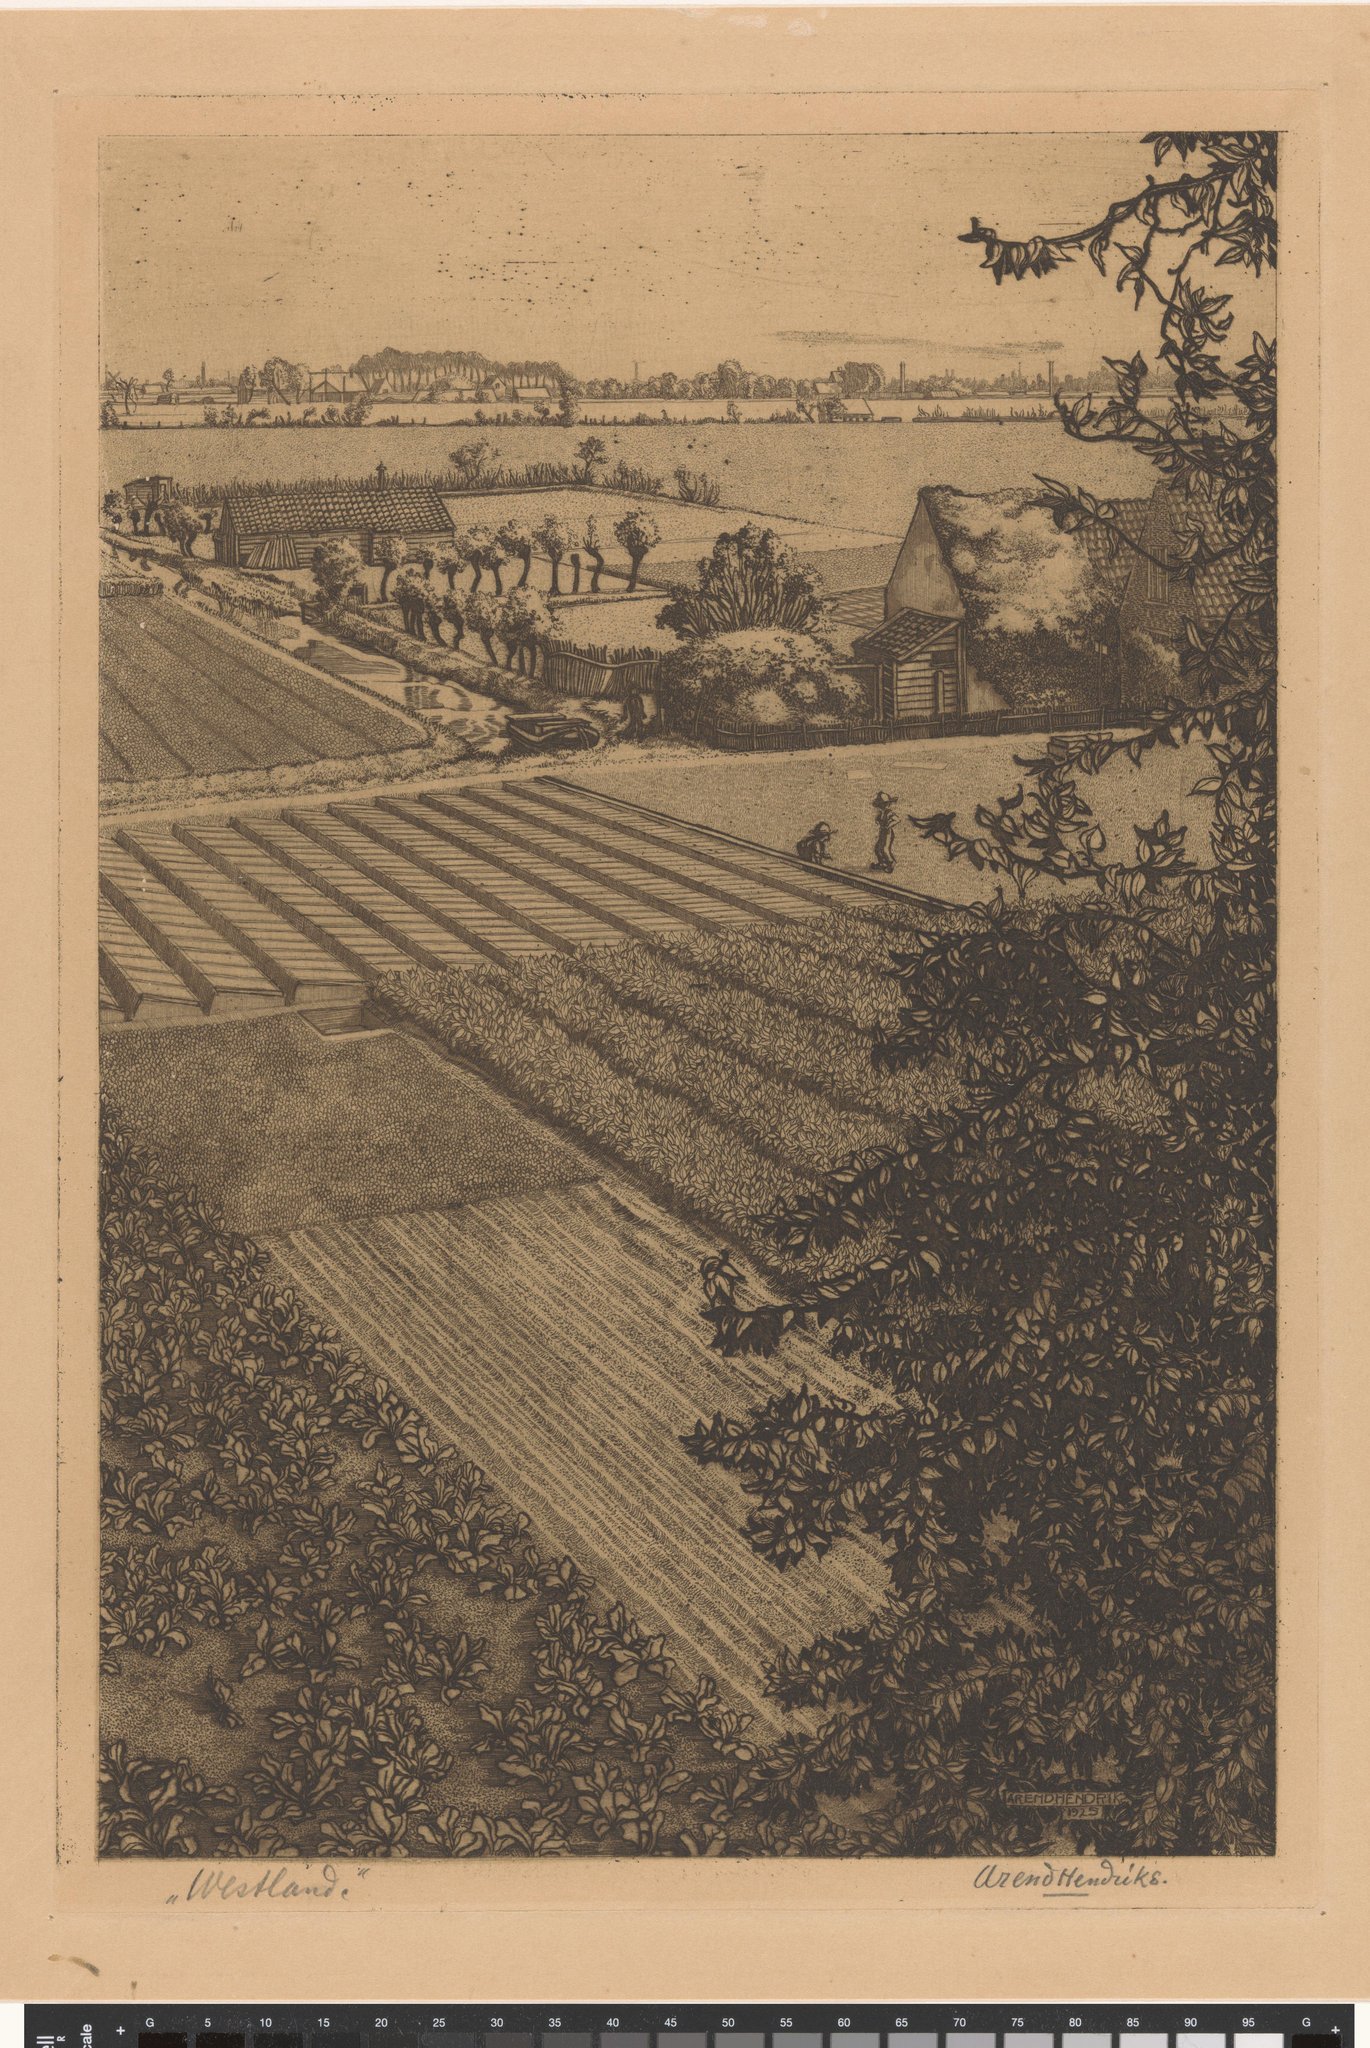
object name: print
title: Westland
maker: arend hendriks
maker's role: print maker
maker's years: 1901-1951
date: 1925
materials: paper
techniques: etching, intaglio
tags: cultivated land, farm or solitary house in landscape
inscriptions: collector's mark: Lugt 2228